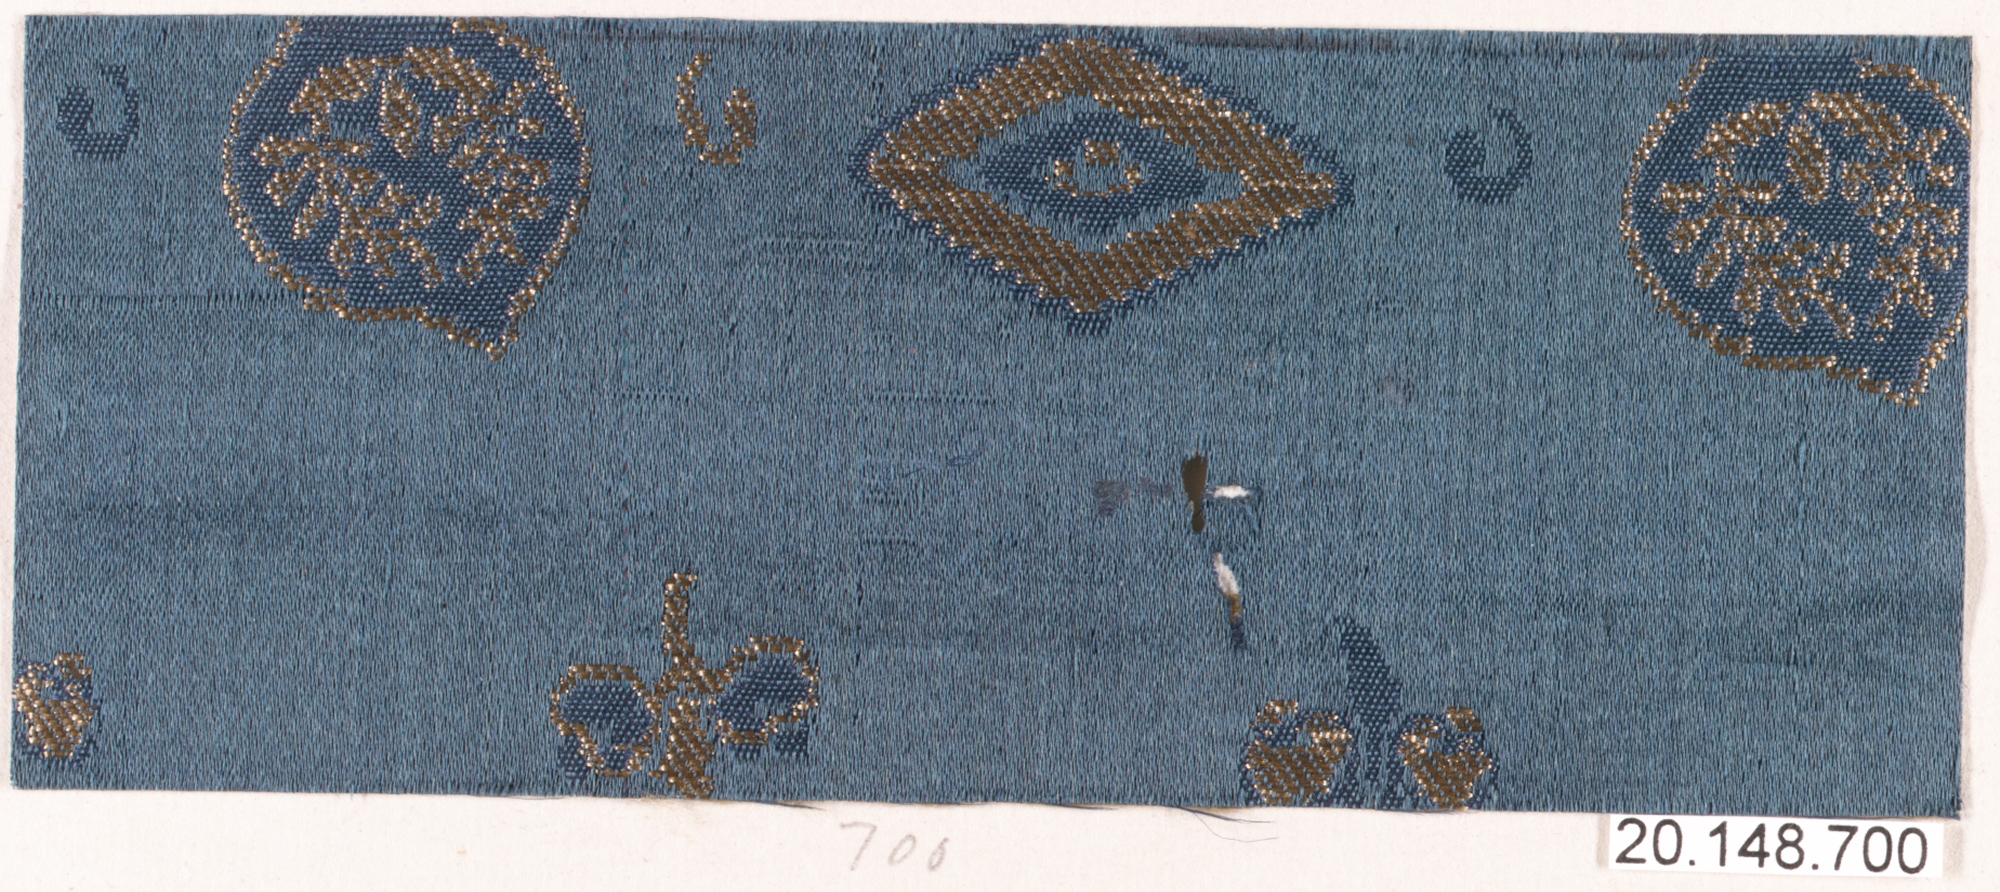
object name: piece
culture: japanese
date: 1601-1700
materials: silk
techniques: compound weave